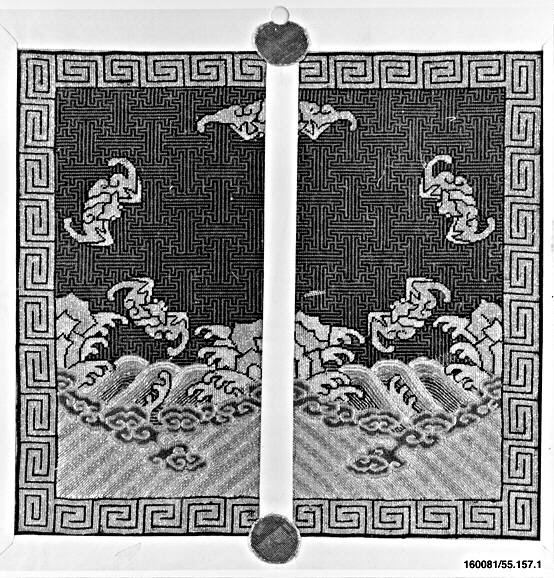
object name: rank badge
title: Rank Badge with Design of Mountains, Waves and Bats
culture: chinese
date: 1867-1933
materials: metal thread, silk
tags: bats,waves